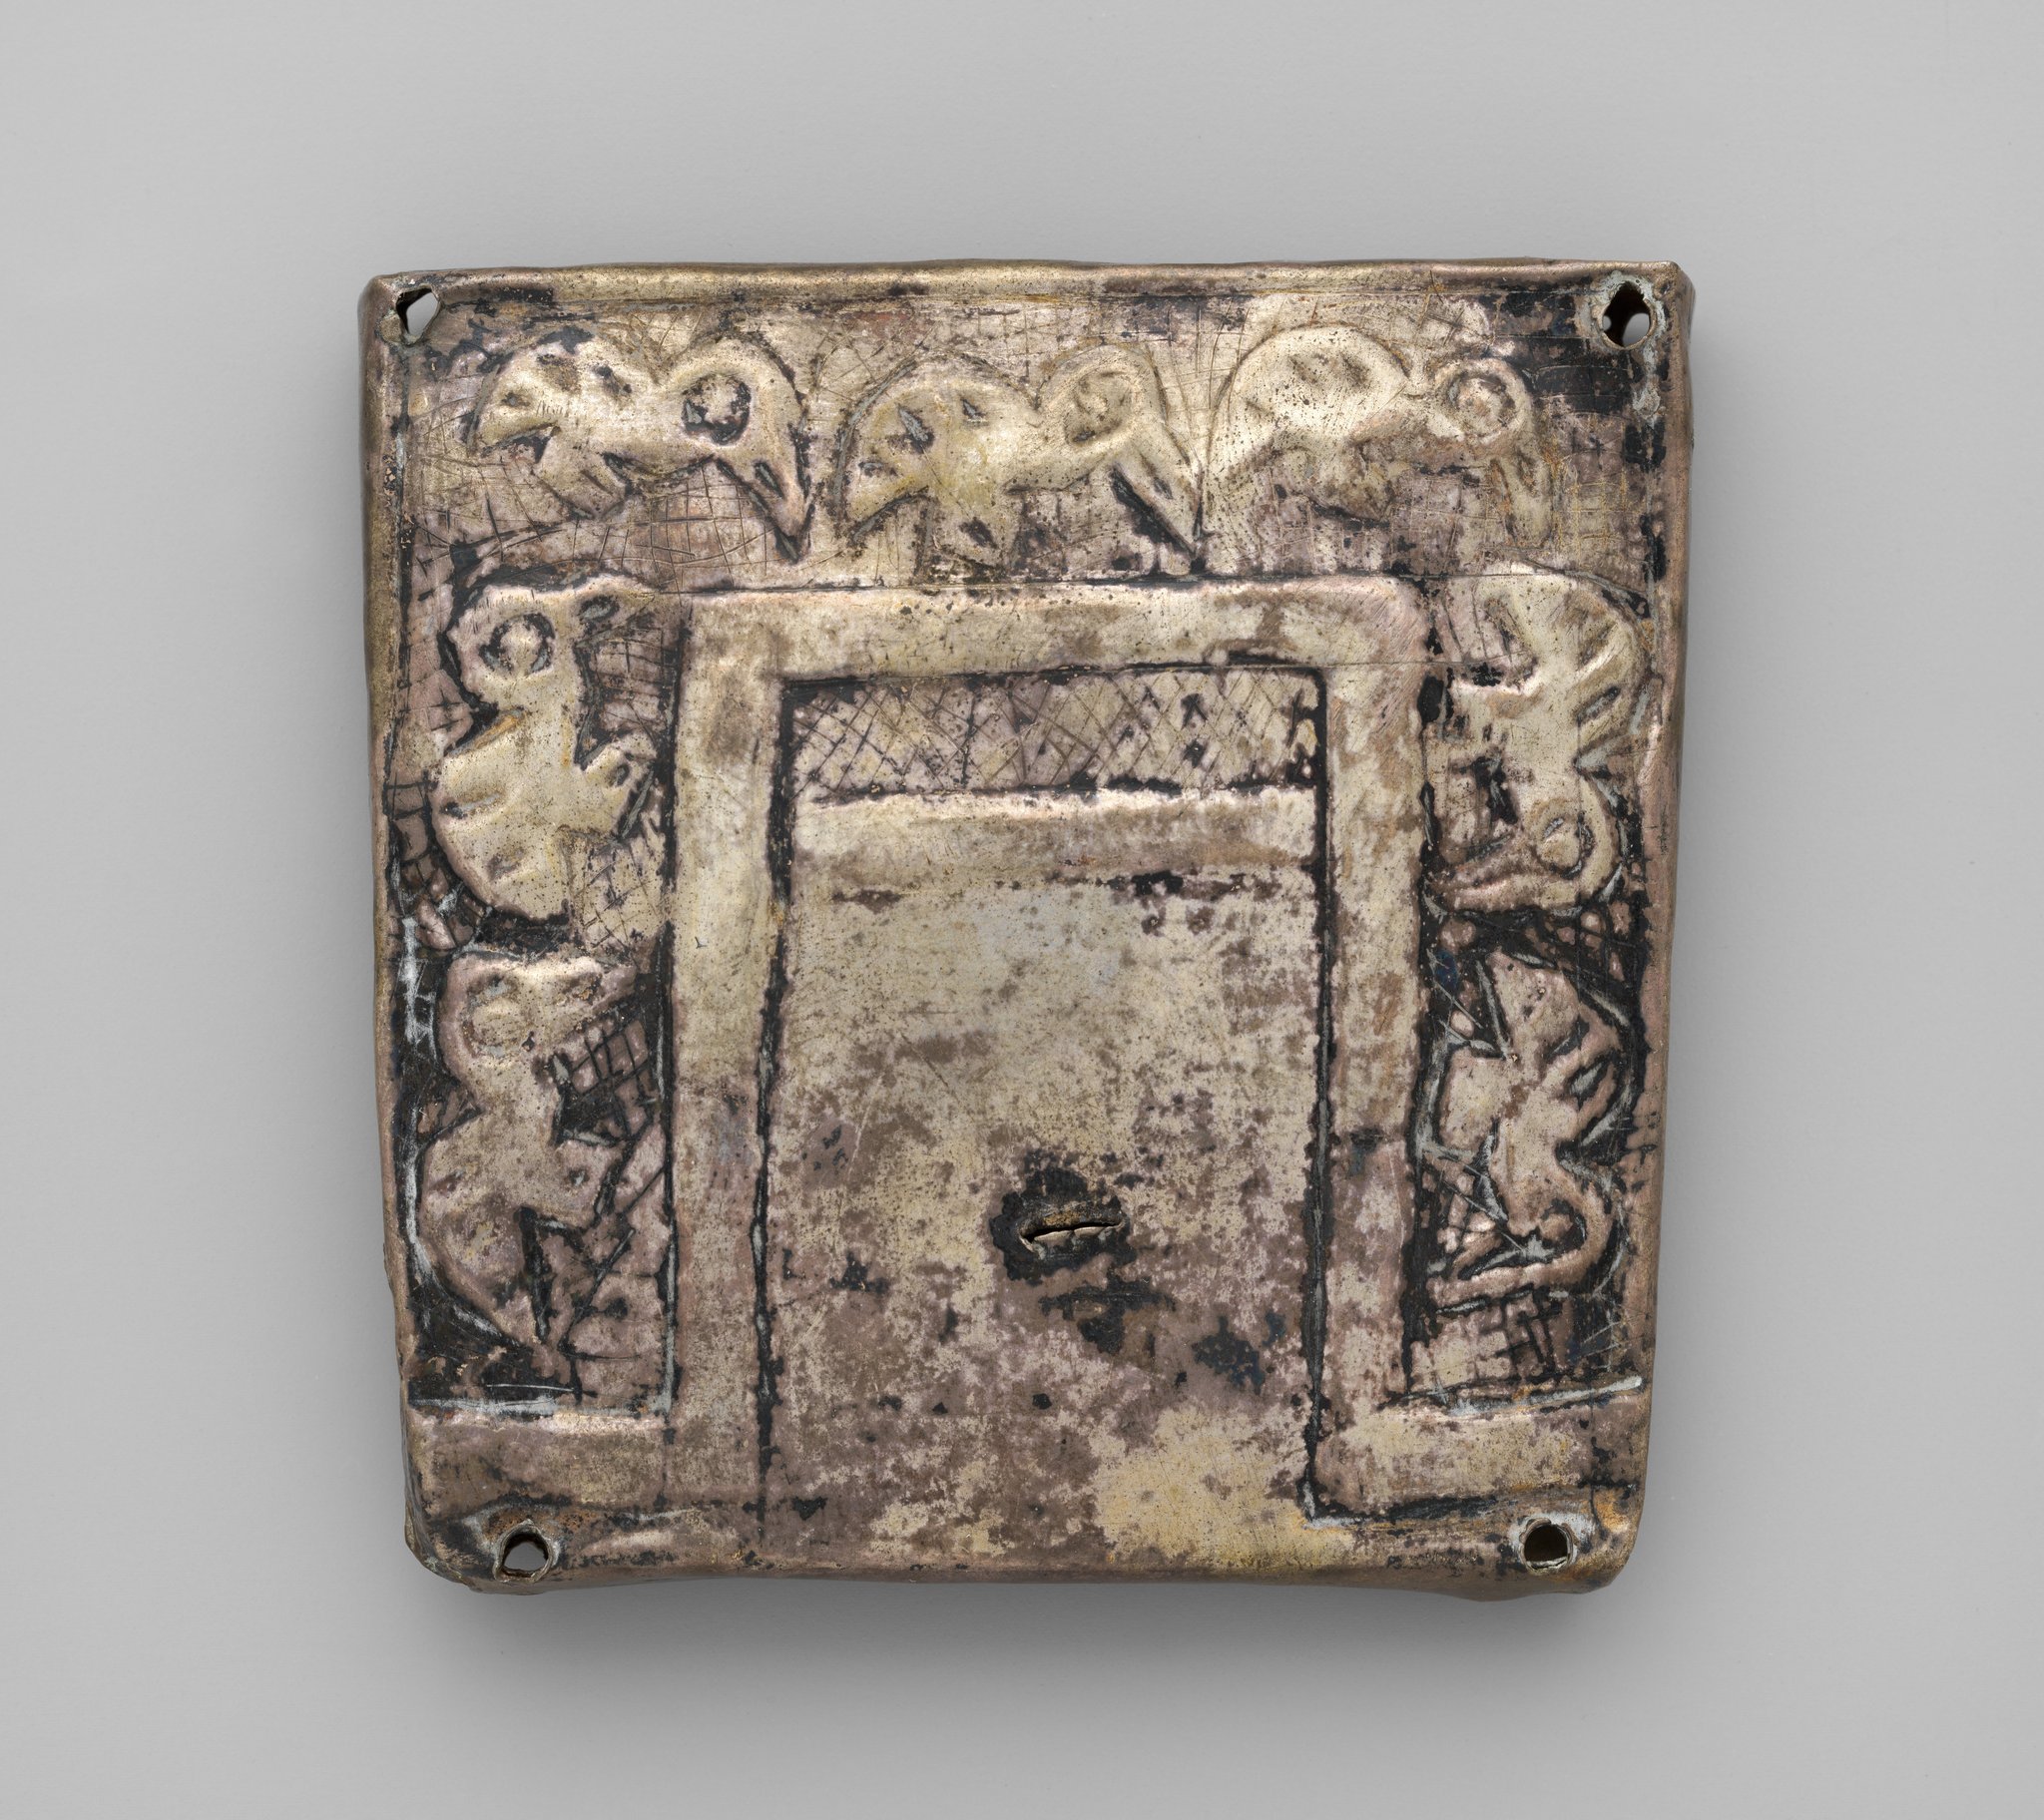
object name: litter backrest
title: Miniature Litter Section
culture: chancay or chimú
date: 1001-1500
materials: gilt, silver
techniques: hammering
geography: peru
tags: birds